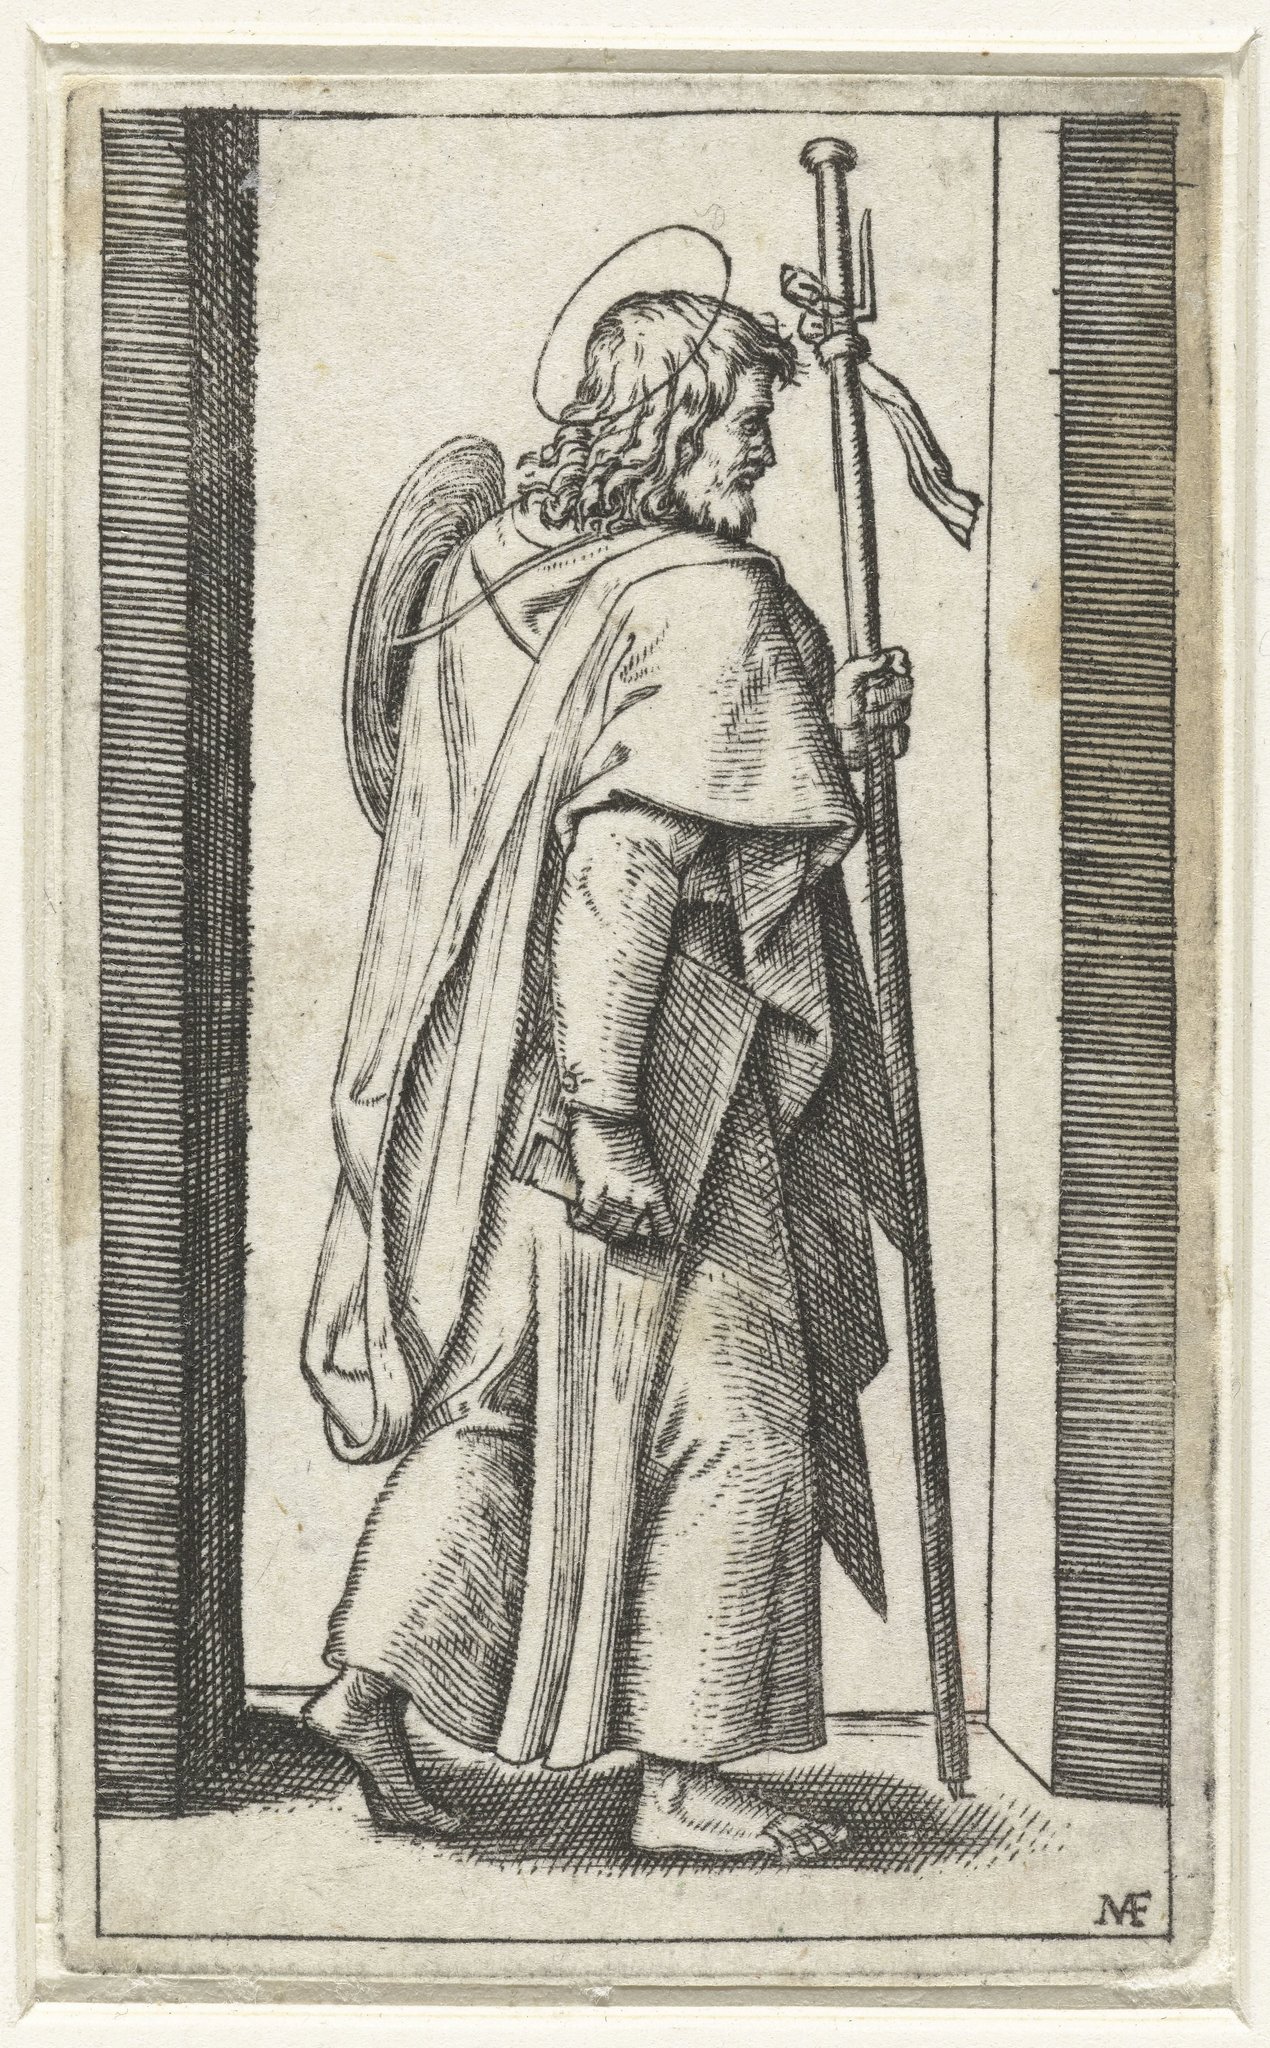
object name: print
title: Christus en de Apostelen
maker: marcantonio raimondi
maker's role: print maker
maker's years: 1470-1534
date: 1517-1527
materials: paper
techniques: engraving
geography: italy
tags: the apostle james the great; possible attributes: book, pilgrim's cloak, hat, shell, staff, and wallet, scroll, sword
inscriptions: collector's mark: Lugt 12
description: Prent maakt deel uit van serie met dertien kleine prenten met Christus en de apostelen.